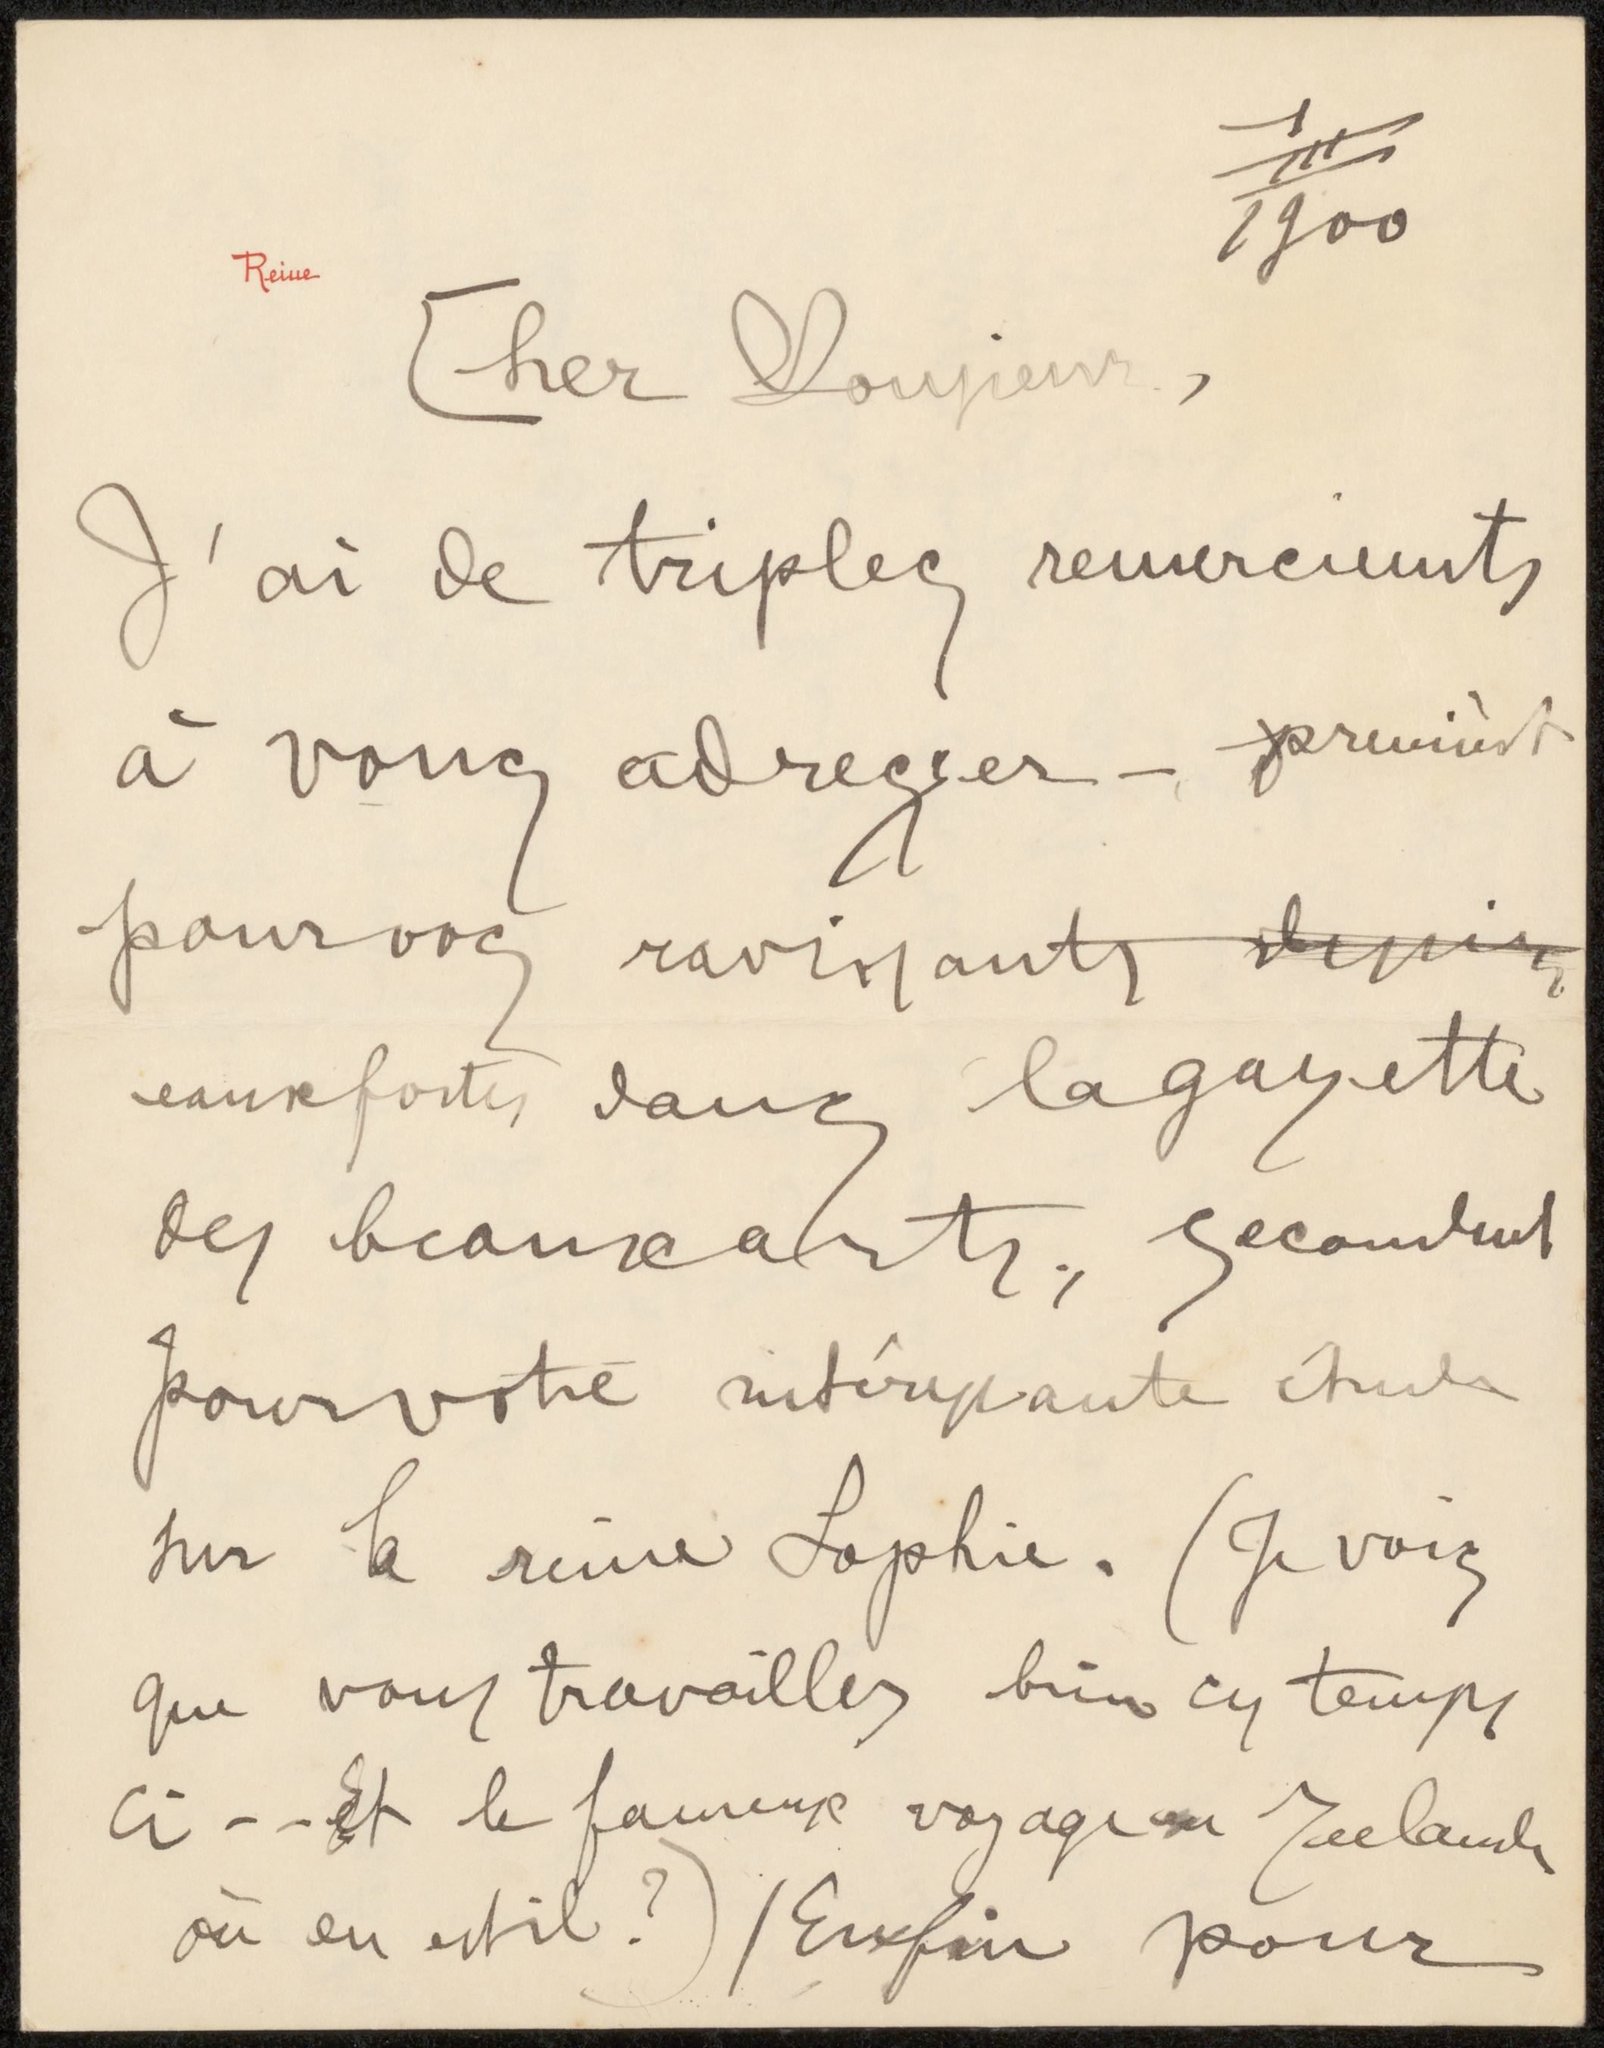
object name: letter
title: Brief aan Philip Zilcken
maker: baronne madeleine deslandes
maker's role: schrijver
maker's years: 1866-1929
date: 1900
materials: ink, paper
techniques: pen, writing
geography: paris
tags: sophia frederika mathilda van württemberg, baronne madeleine deslandes, painter, draughtsman, philip zilcken, literature ~ arts, the graphic arts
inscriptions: collector's mark: ‘RPK’